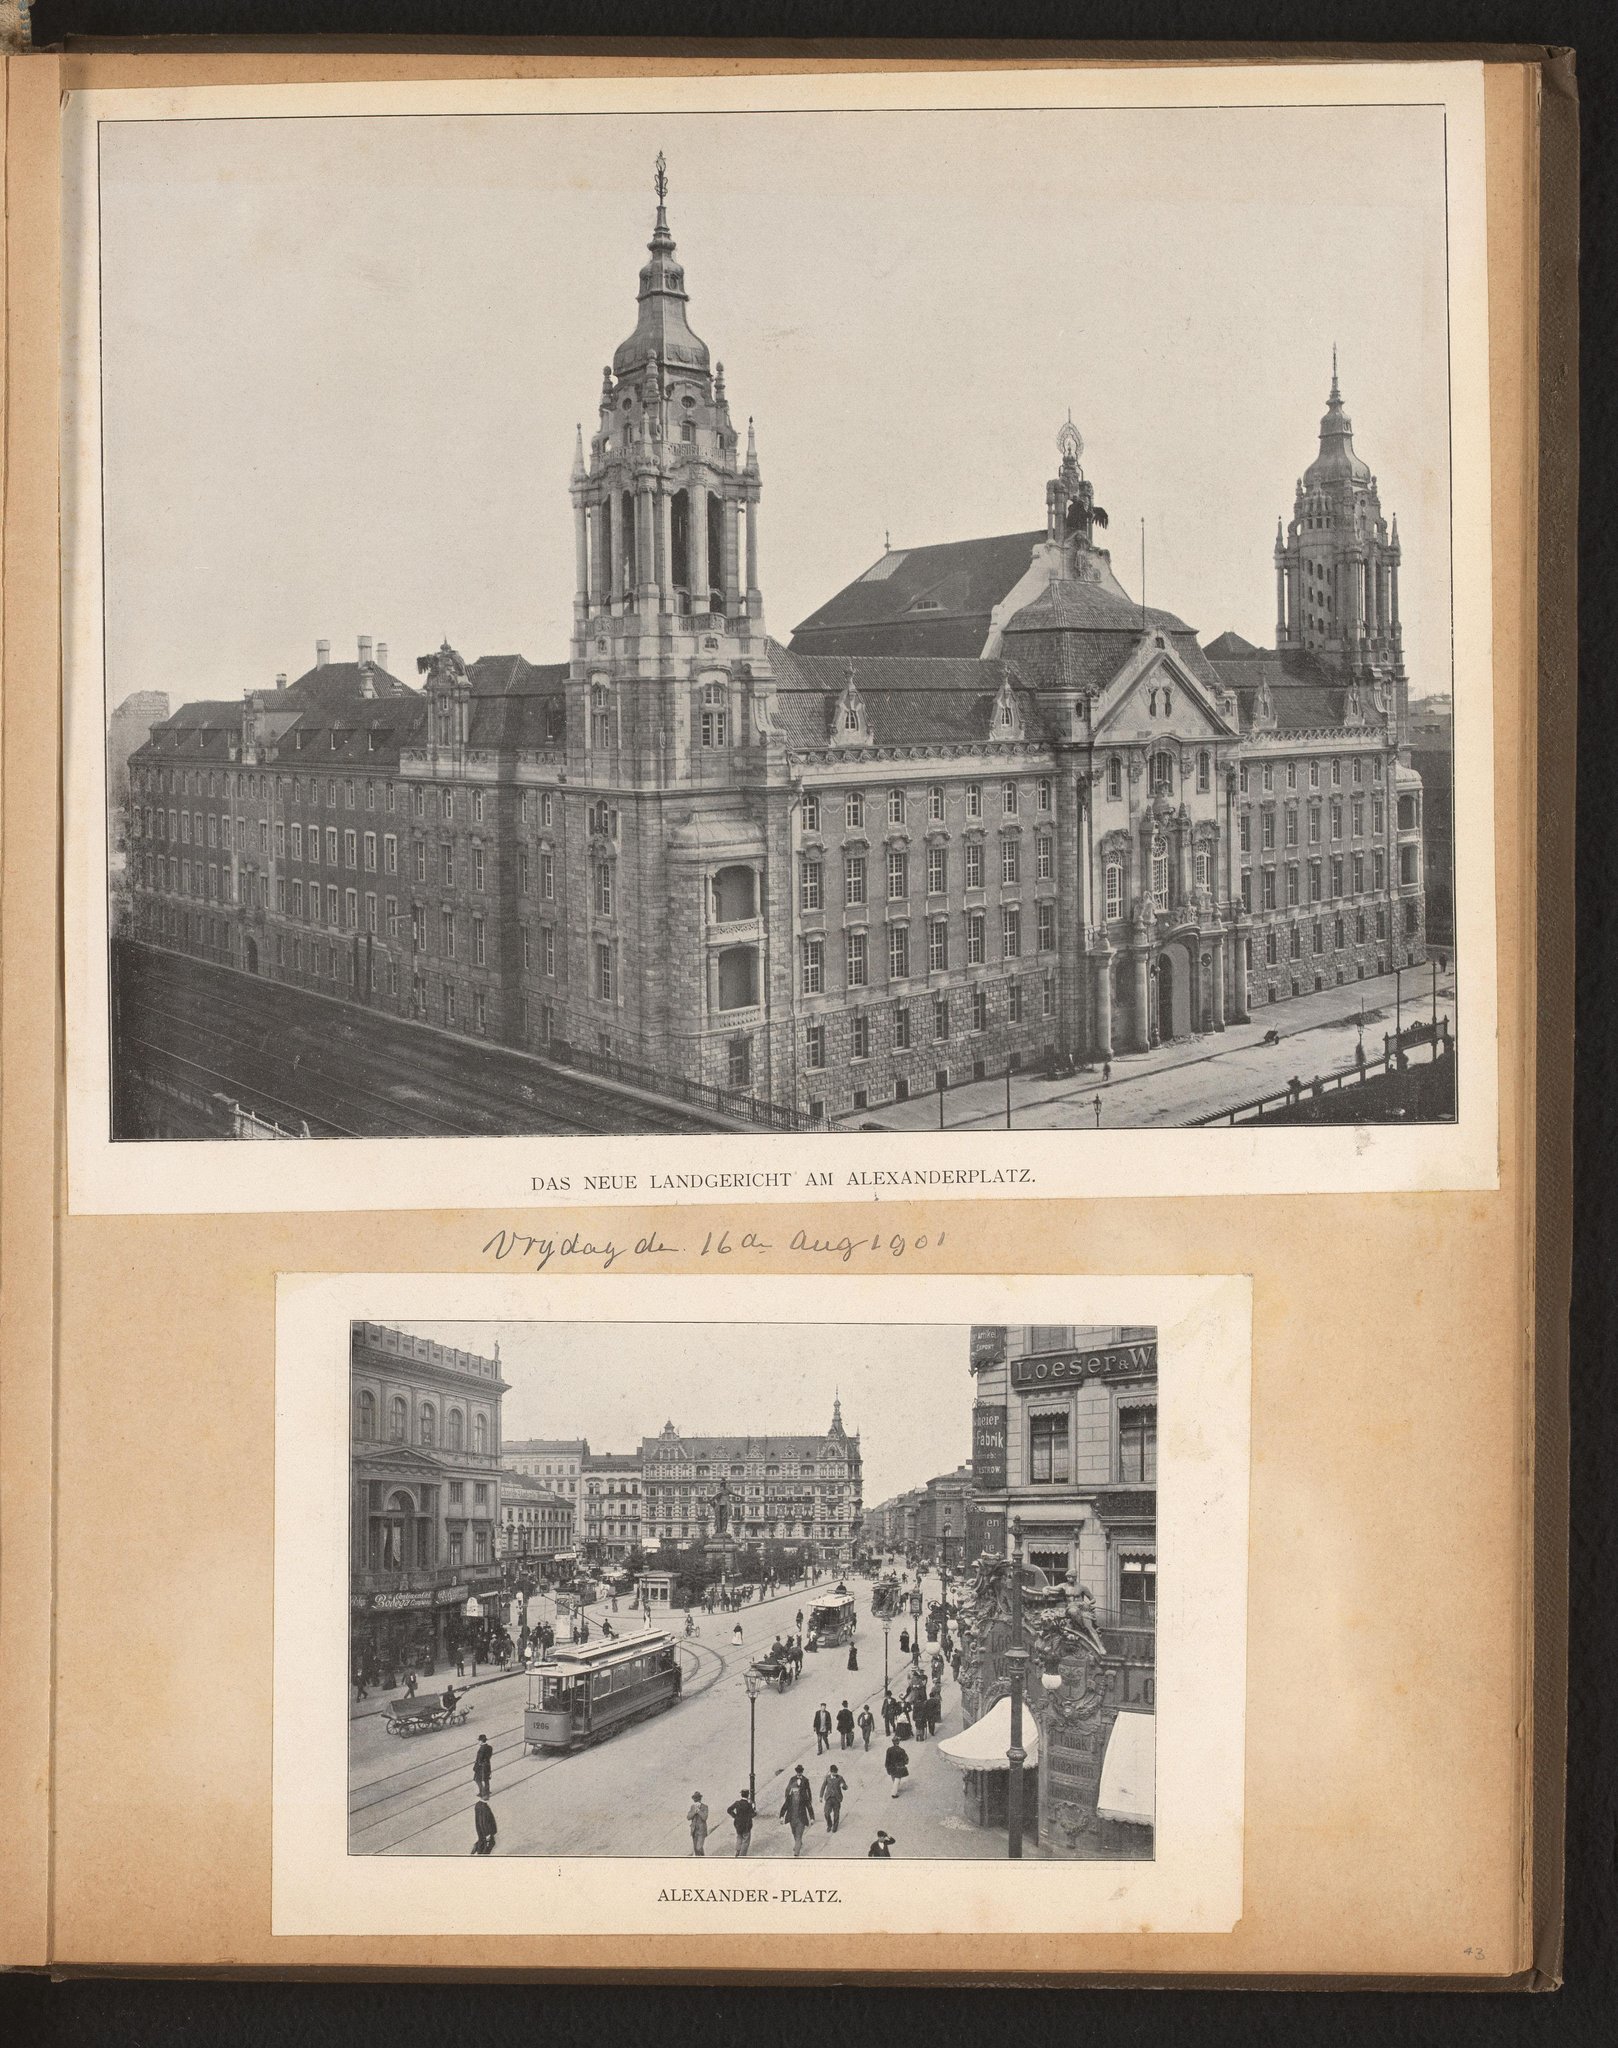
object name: photomechanical print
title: Gezicht op het Landgericht en de Alexanderplatz, Berlijn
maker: Anonymous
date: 1896-1901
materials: paper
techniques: autotype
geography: berlin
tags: court building, village square, place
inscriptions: title: ‘Alexander-Platz.’, inscription: ‘Vrijdag den 16de Aug 1901’, title: ‘Das neue Landgericht am Alexanderplatz.’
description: Deze fotomechanische afdrukken maken deel uit van een album.